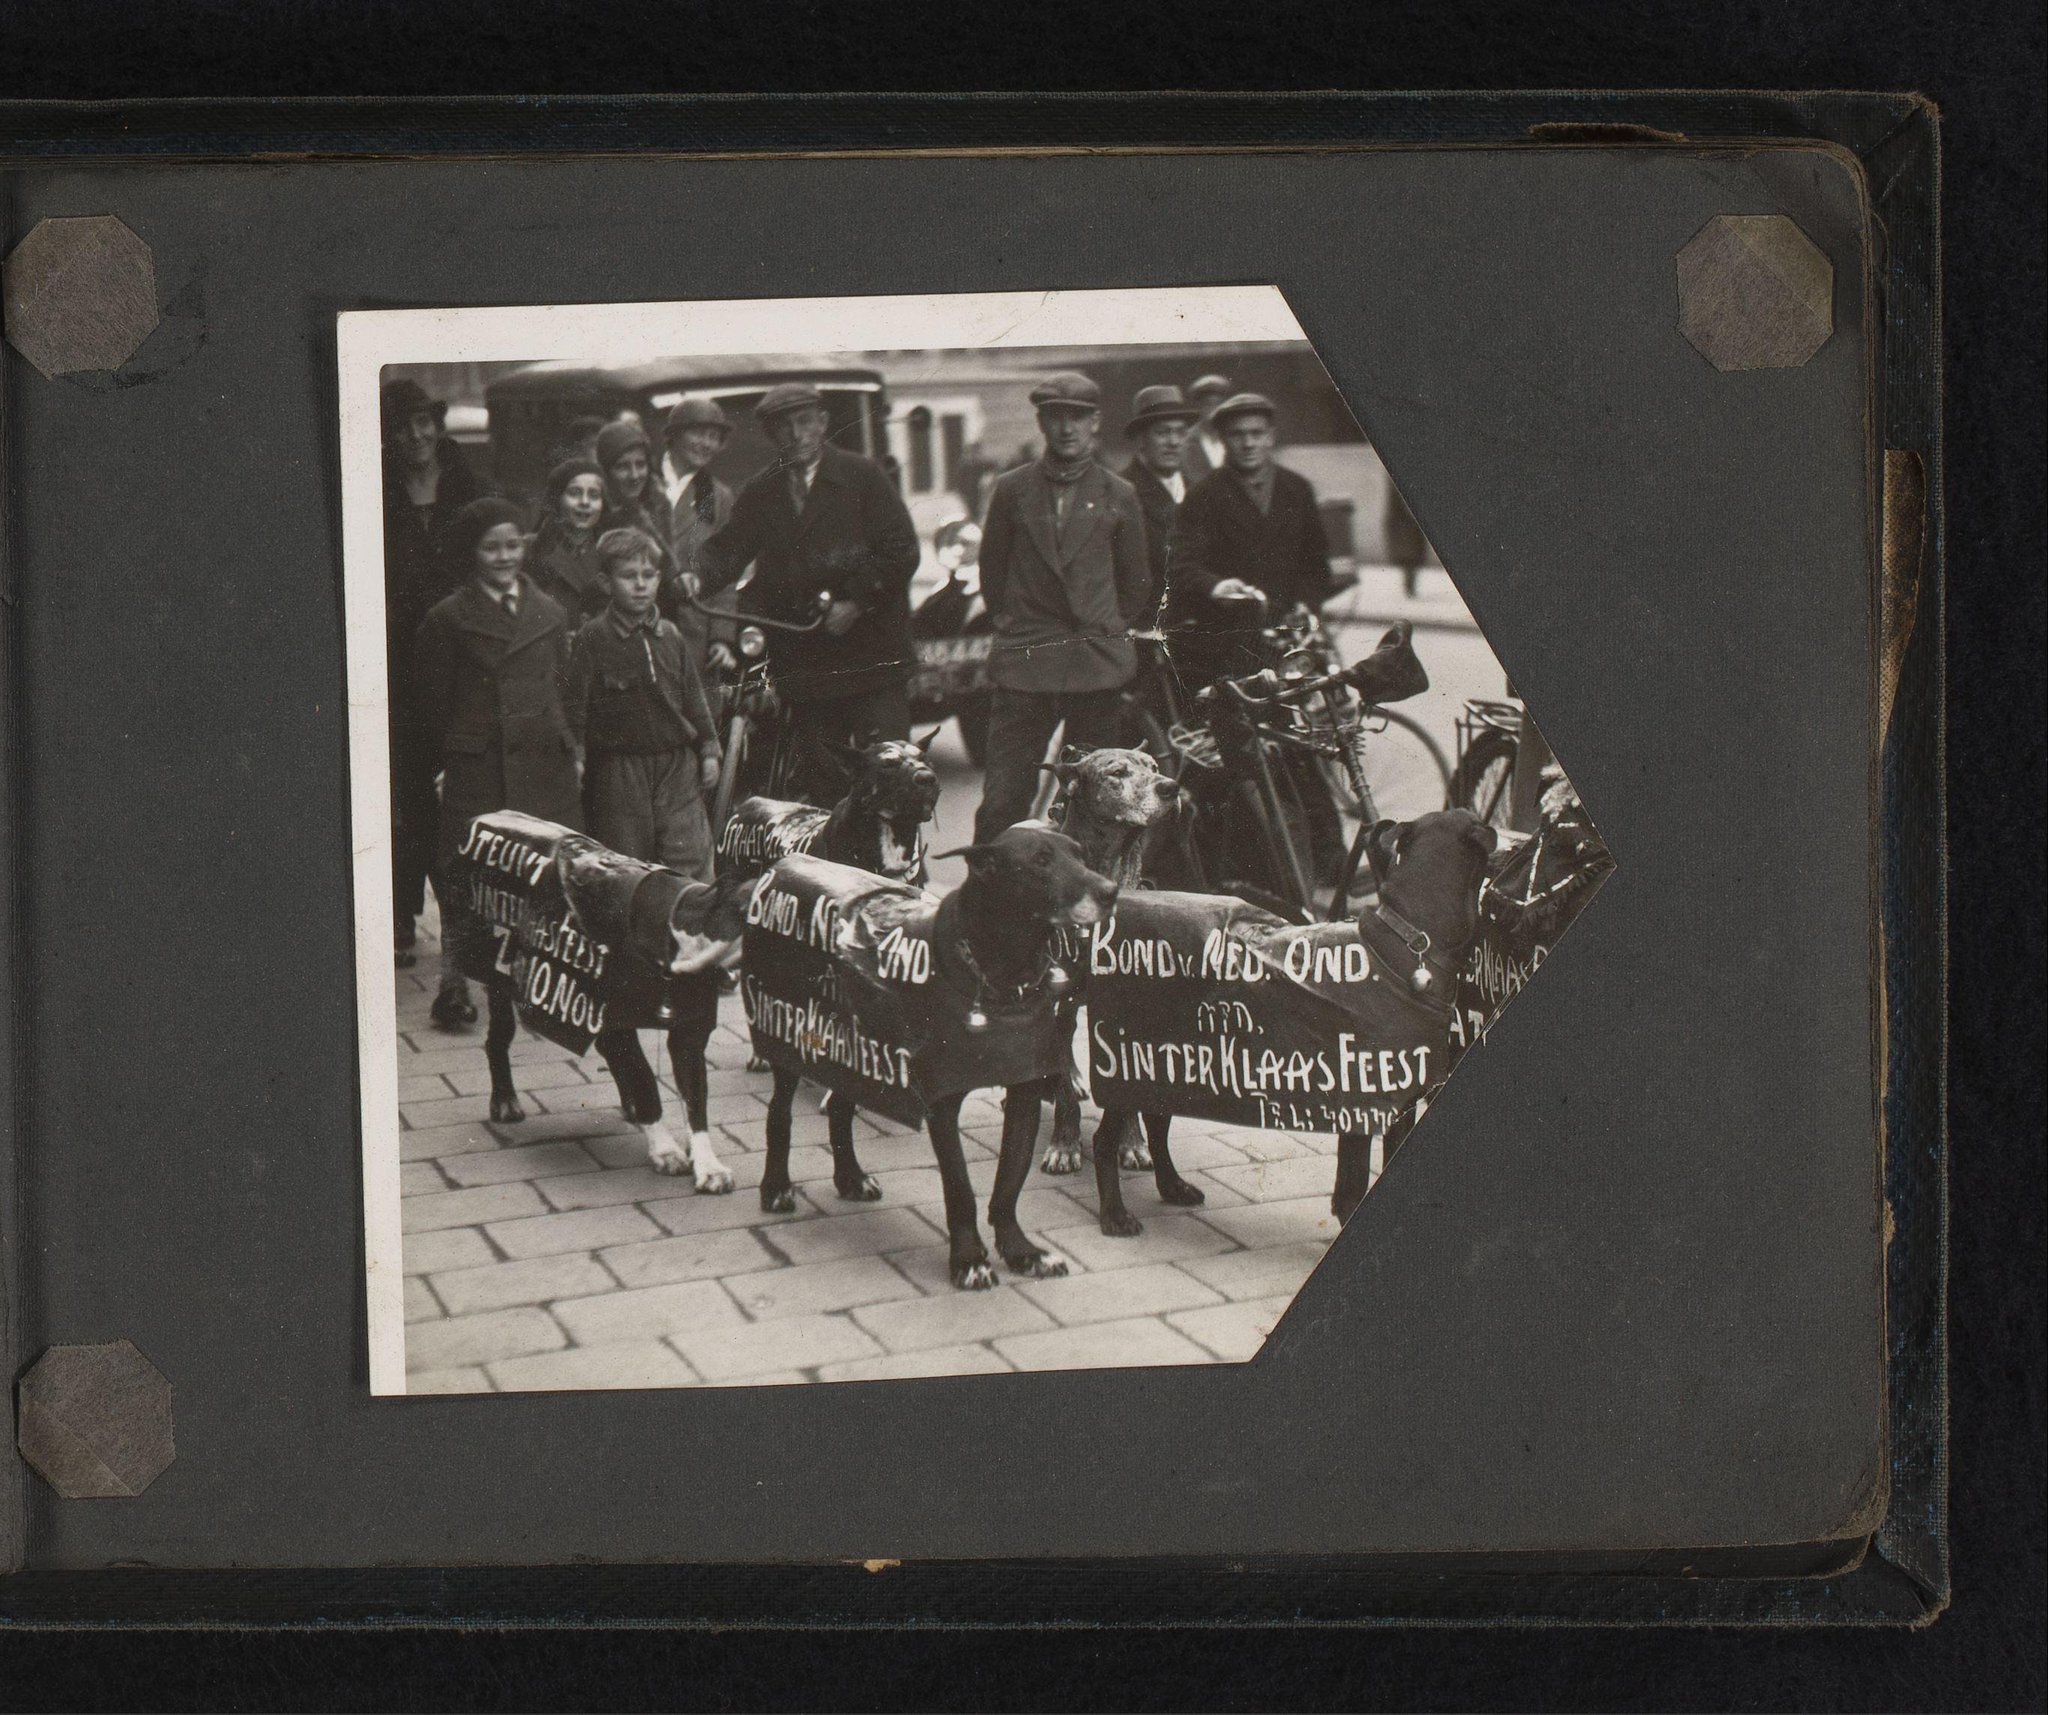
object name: photograph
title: Honden met reclameteksten voor Sinterklaasaktie van de Bond van Ned. Ond. te Amsterdam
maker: Anonymous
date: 1930-1940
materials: photographic support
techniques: gelatin silver print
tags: advertising, street, dog